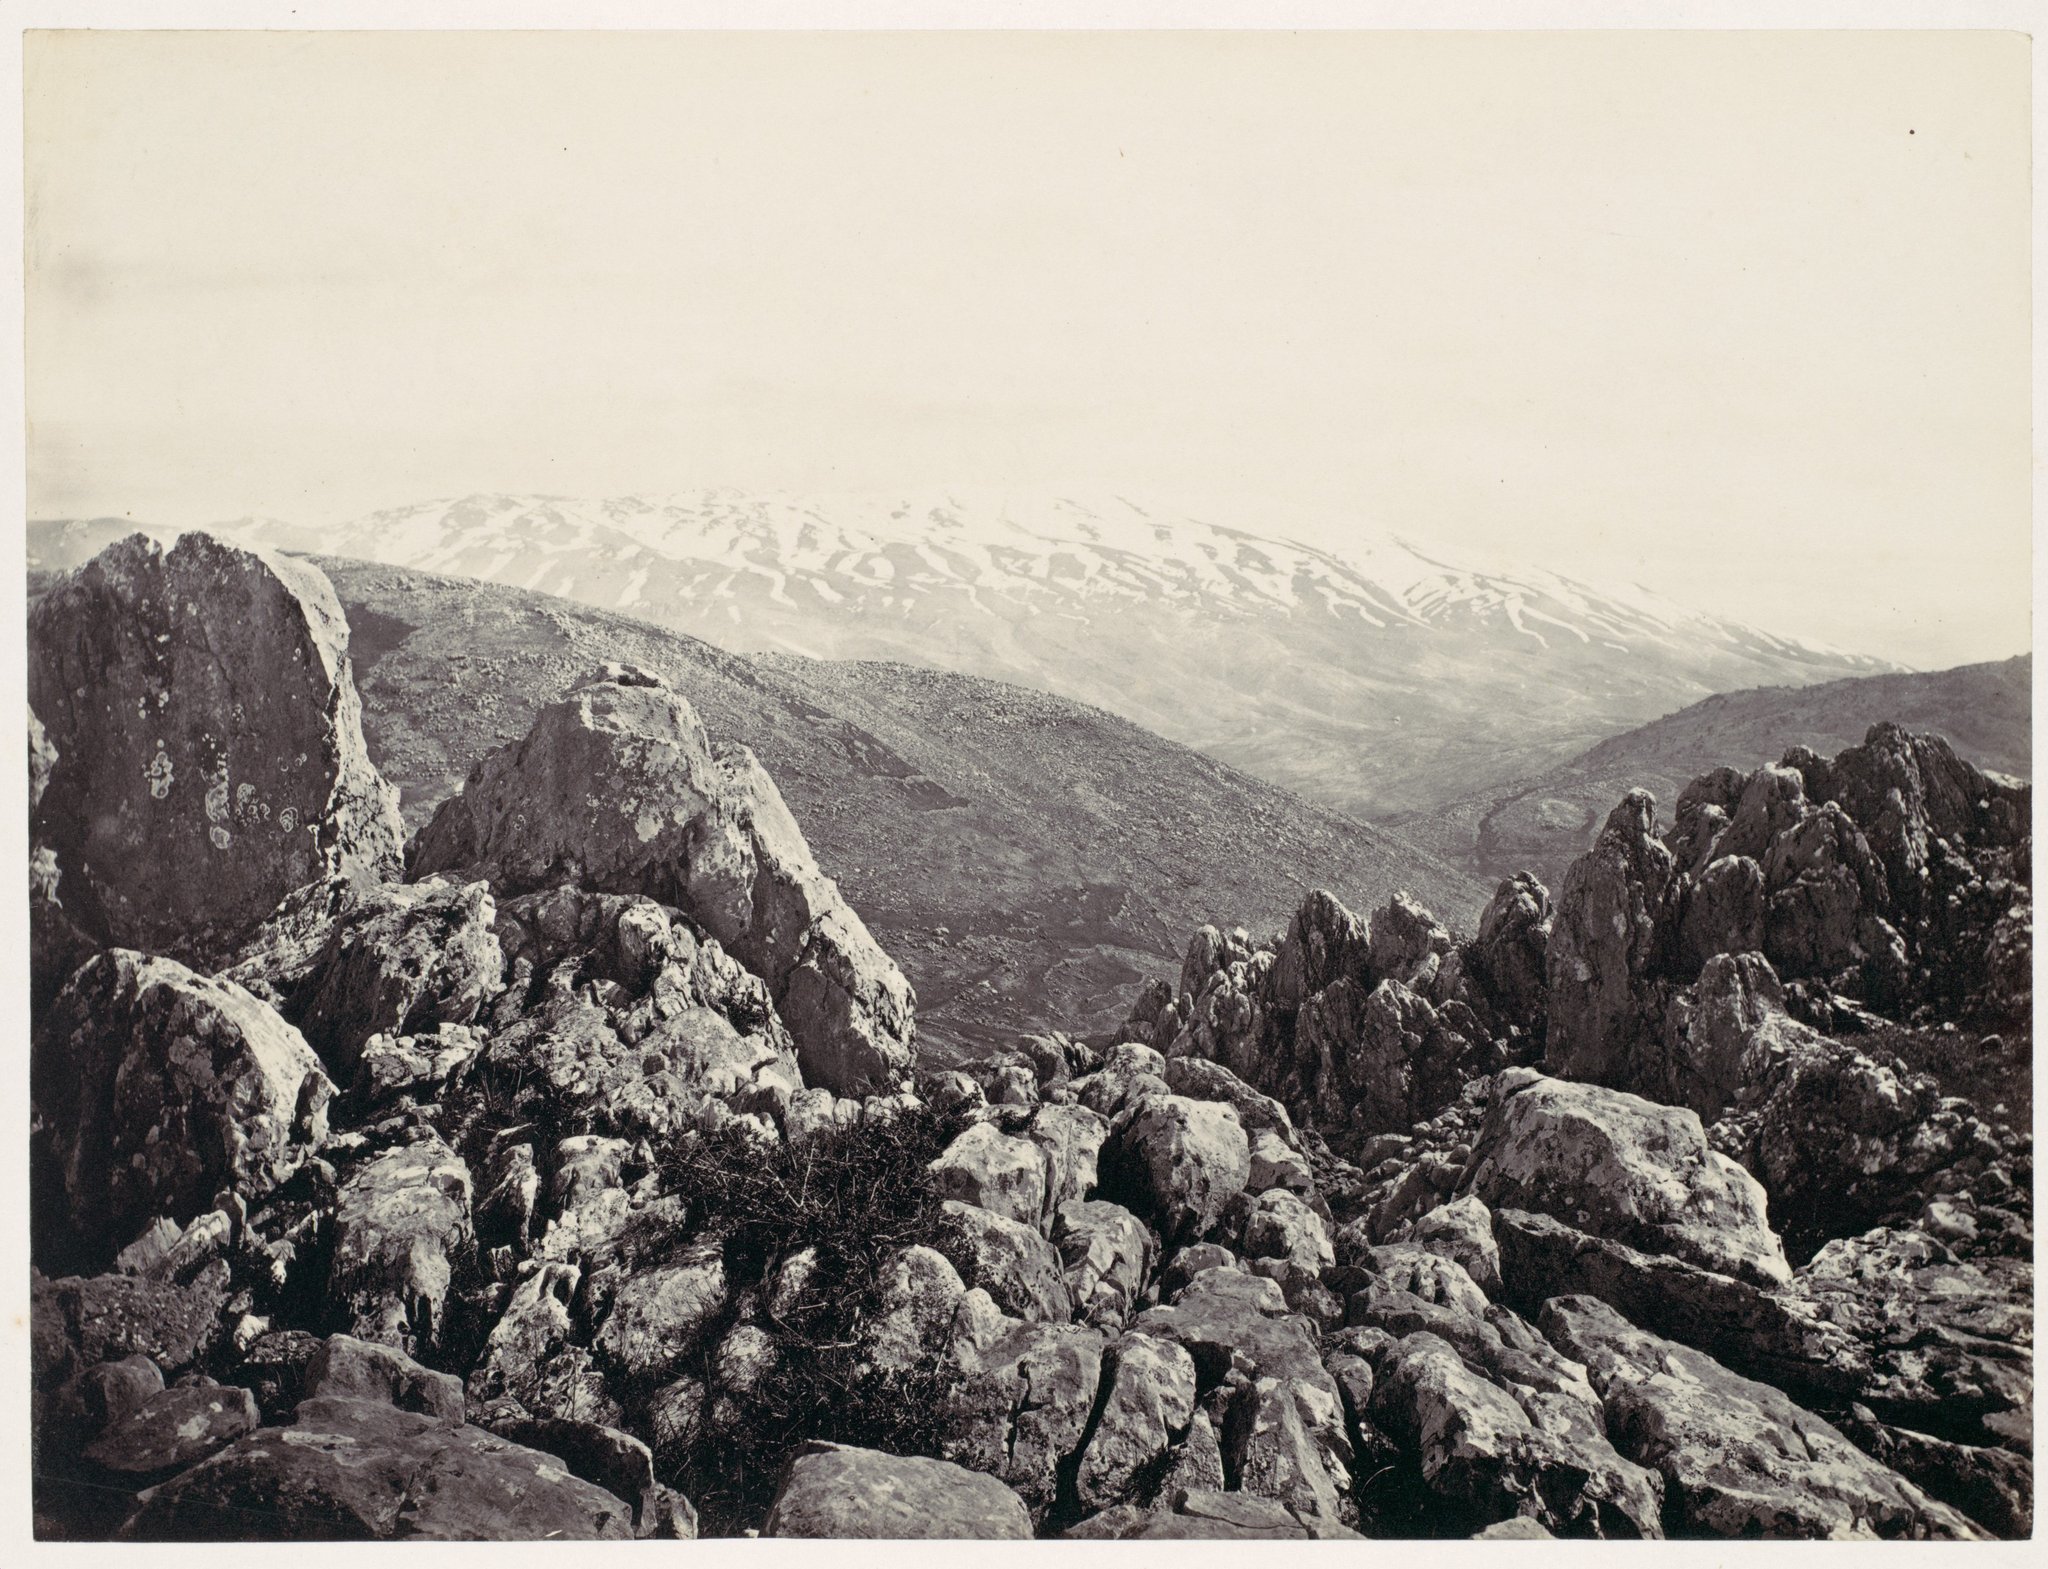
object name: photograph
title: Mount Hermon, The Mount of Transfiguration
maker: francis frith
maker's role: publisher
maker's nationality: english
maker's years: 1822-1898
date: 1857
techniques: albumen silver print, glass negative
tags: mountains,landscapes